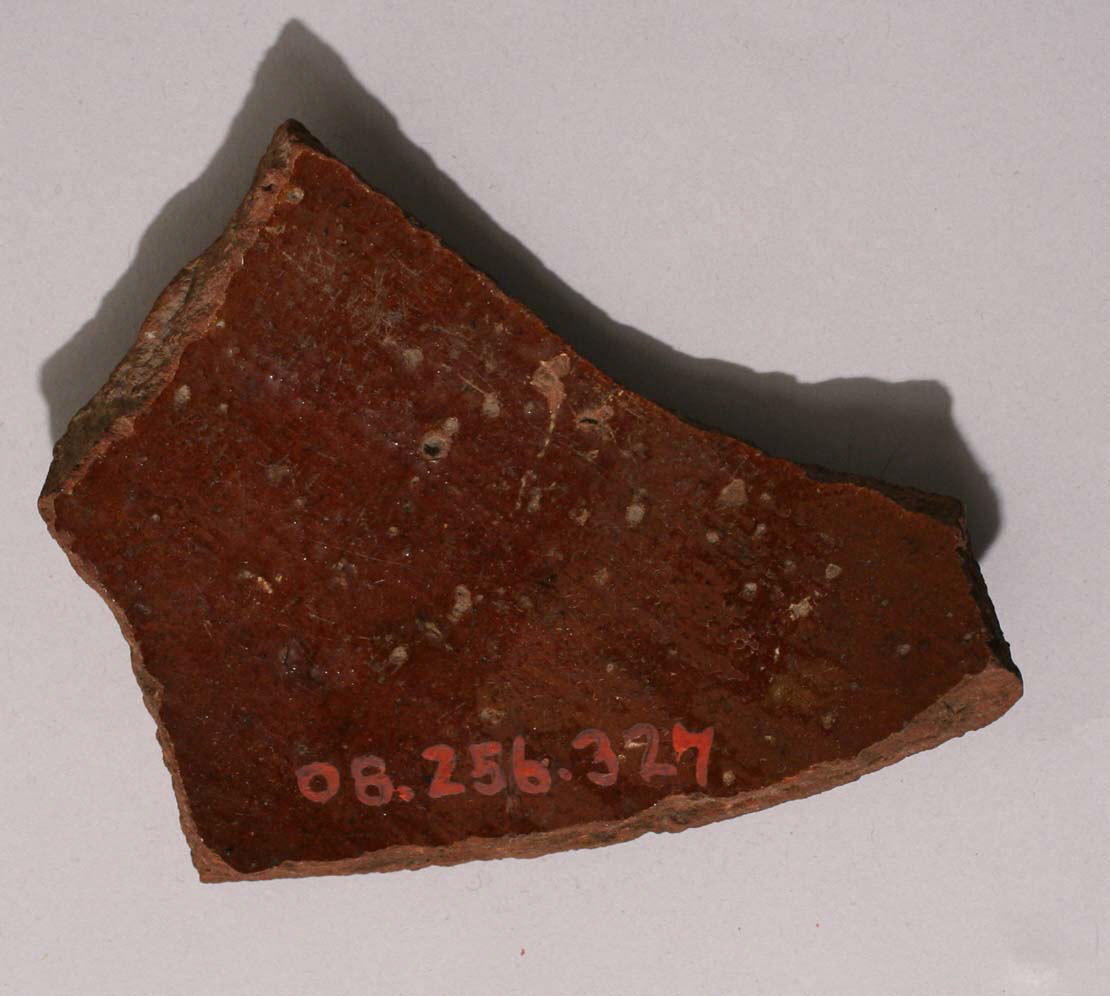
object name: fragment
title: Ceramic Fragment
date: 1301-1500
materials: earthenware, glaze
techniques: coloring, incising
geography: egypt